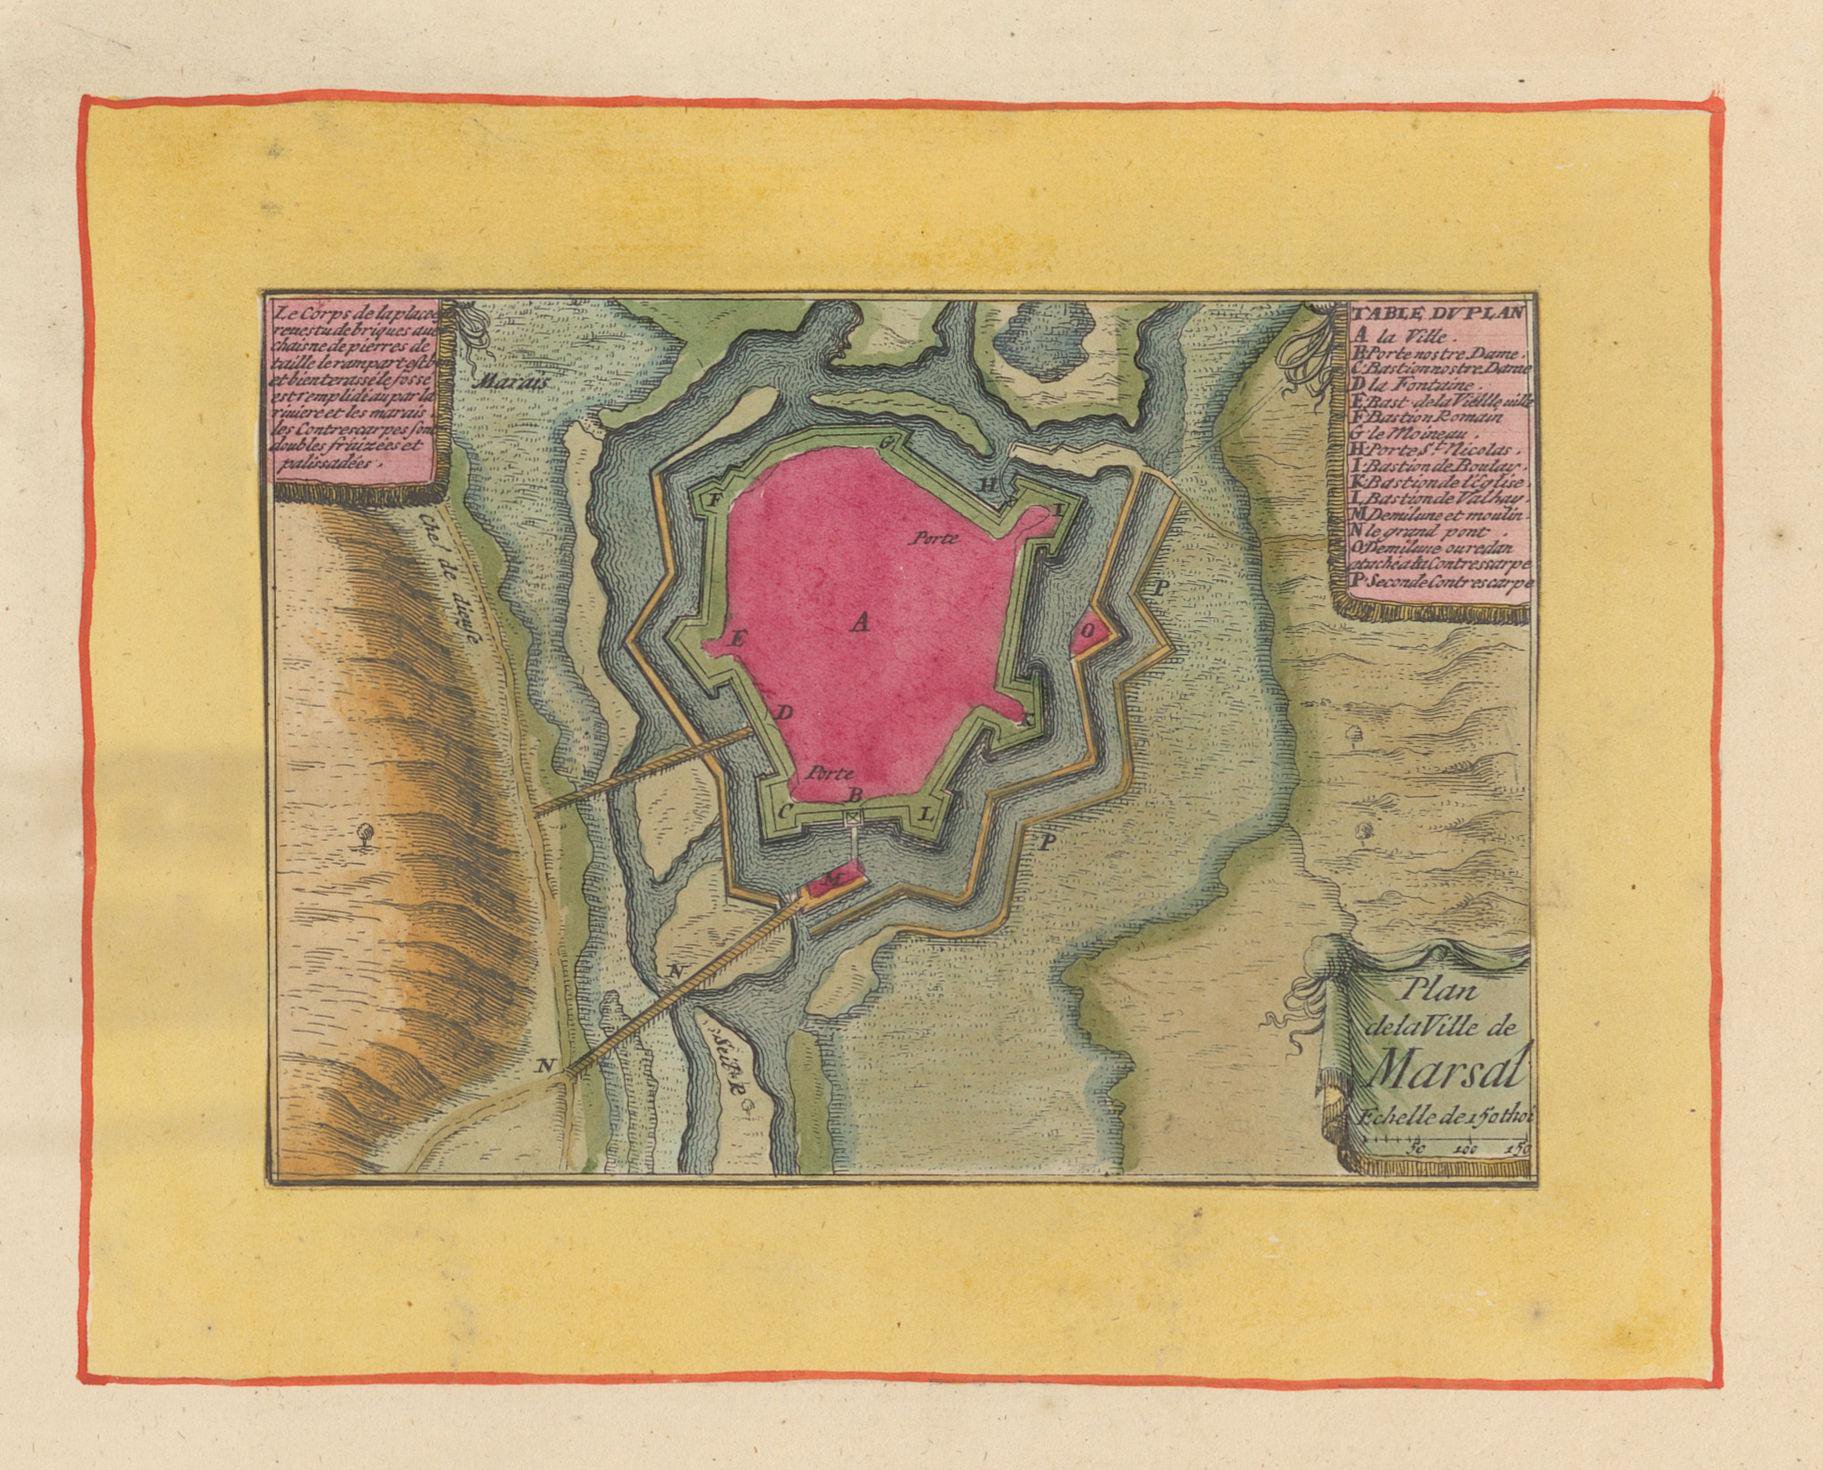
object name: area plan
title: Plan de la ville de Marsal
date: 1702-1729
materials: paper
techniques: engraving, hand coloring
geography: the hague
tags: maps of cities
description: Deze plattegrond is in meerdere atlassen gebruikt. Onder andere in: Les forces de l'Europe. 10 dln. Amsterdam: Pieter Mortier, ca. 1700. En in: Les forces de l'Europe. 12 dln. Amsterdam: Pieter Mortier, 1702. Door het ontbreken van de marges van deze prent is onduidelijk om welke staat het gaat. Derhalve is niet te bepalen uit welke van deze publicaties dit exemplaar komt. Later is deze zelfde prent door Pieter van der Aa gebruikt in twee publicaties. Gezien het eind van de werkzame periode van de inkleurder van de prenten in dit album is het niet mogelijk dat deze prent uit een van die publicaties komt.